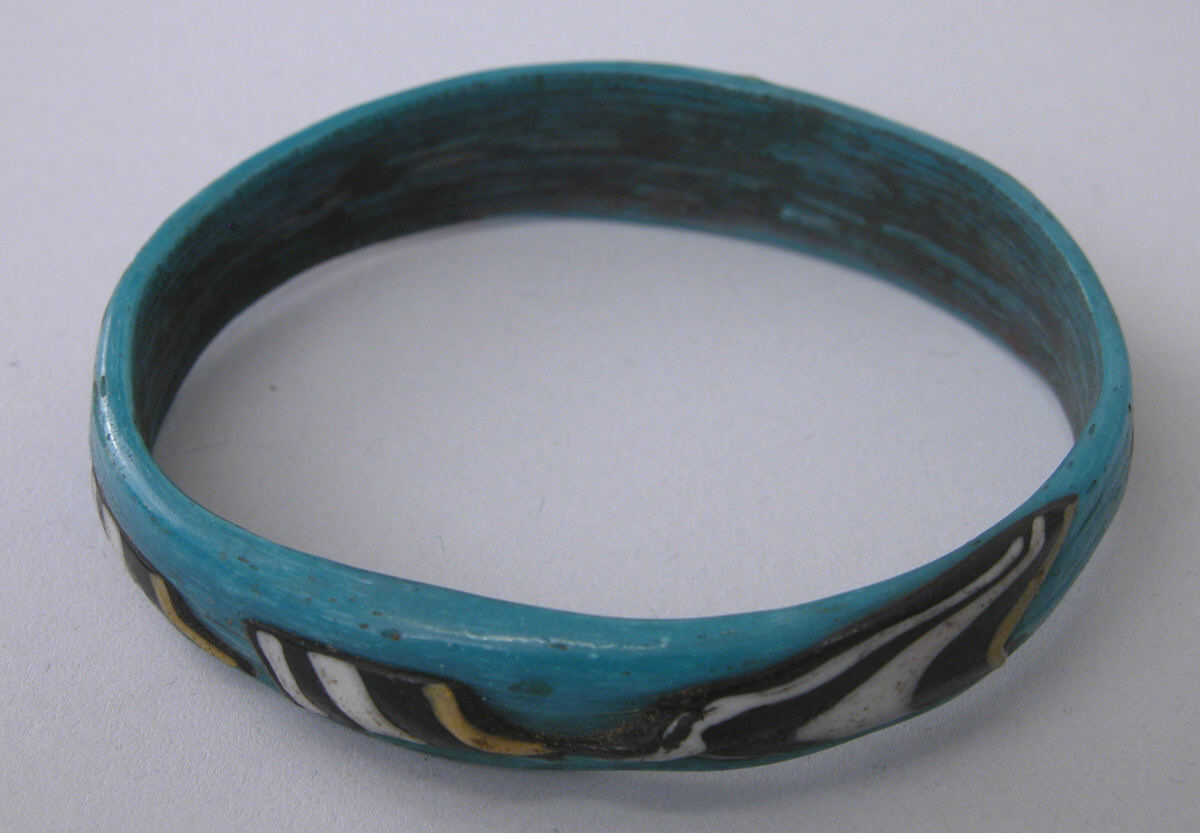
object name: bracelet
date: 1301-1500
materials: glass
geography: egypt or syria